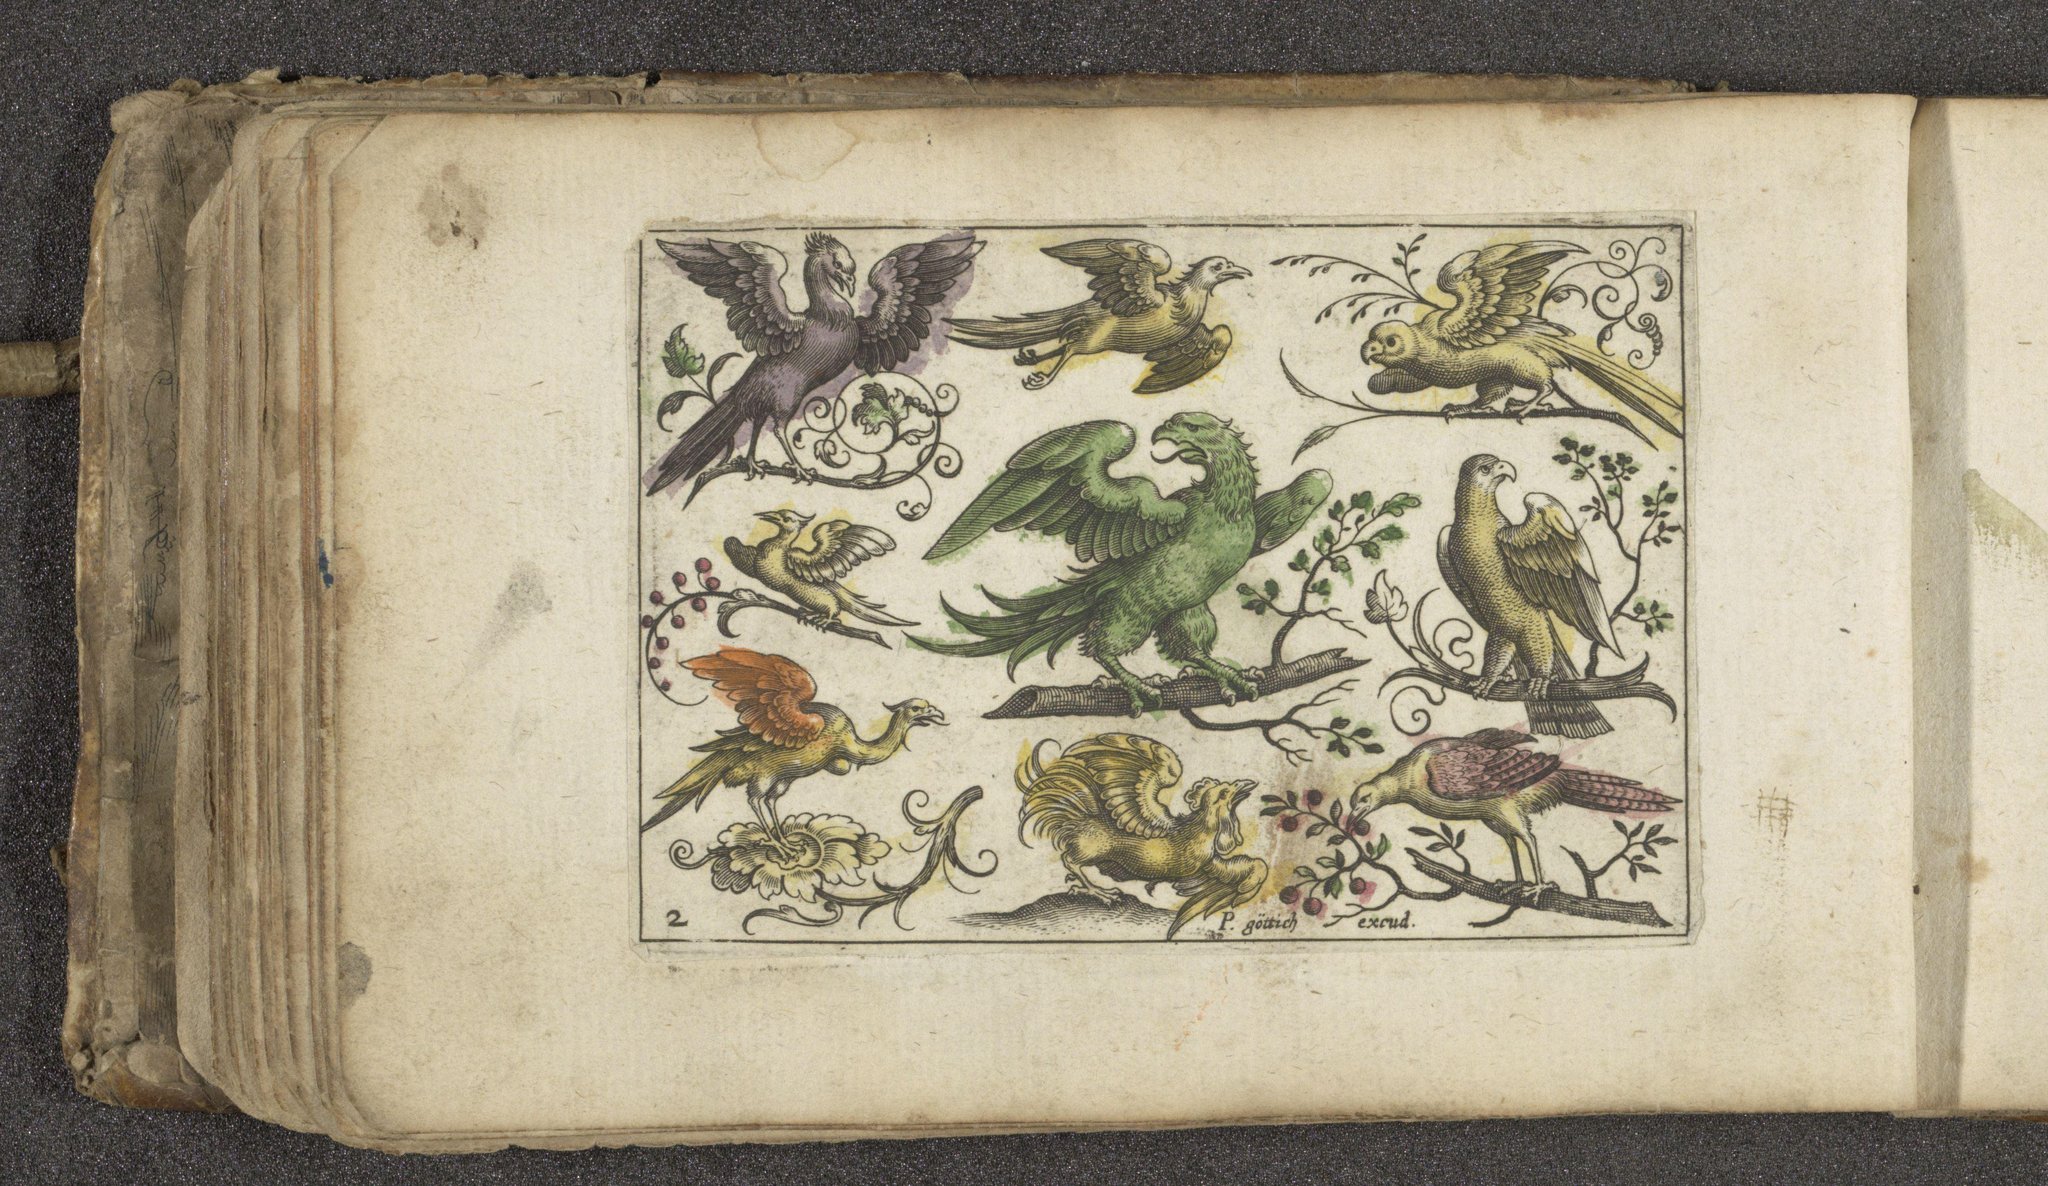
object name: ornament print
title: Roofvogel en tien andere vogels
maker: paul göttich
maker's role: graveur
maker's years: 1586-1622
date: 1596-1622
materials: paper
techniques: colour, engraving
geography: augsburg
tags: birds, predatory birds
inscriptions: inscription: ‘54’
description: Een roofvogel op een tak, omringd door tien andere vogels. De prent maakt deel uit van een album.